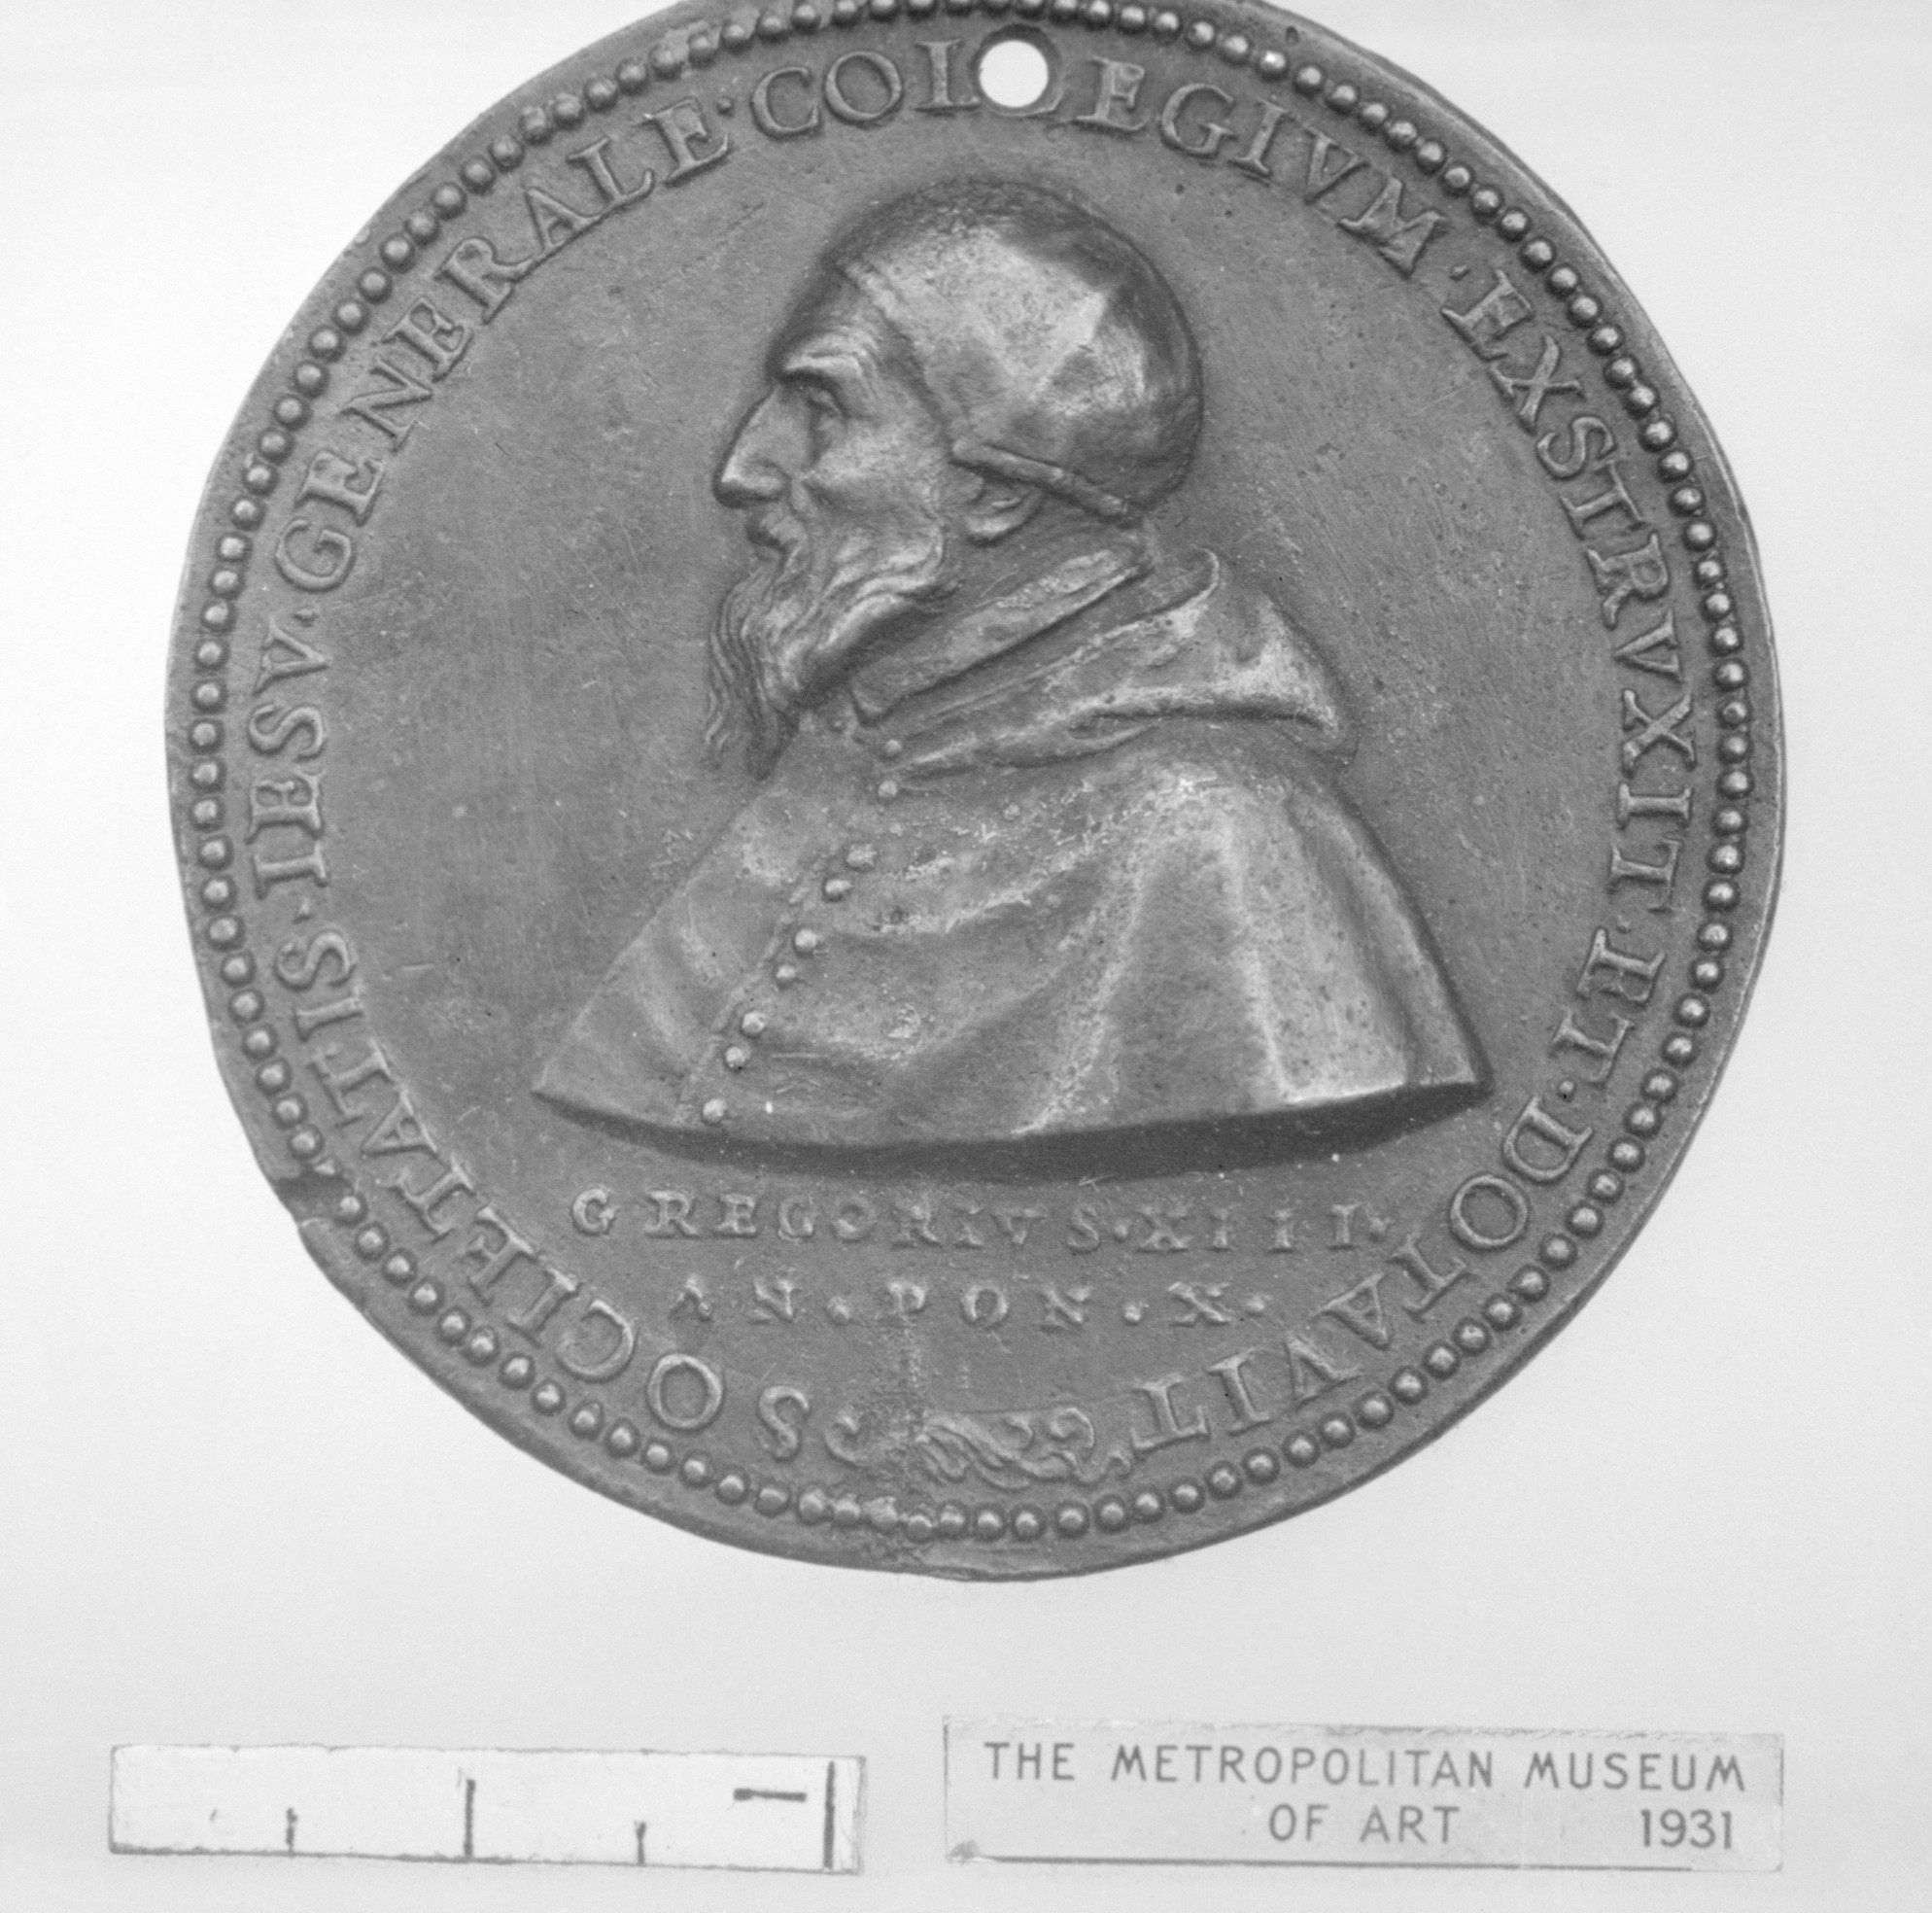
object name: medal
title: Pope Gregory XIII (r. 1572–85)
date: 1501-1600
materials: bronze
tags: profiles,popes